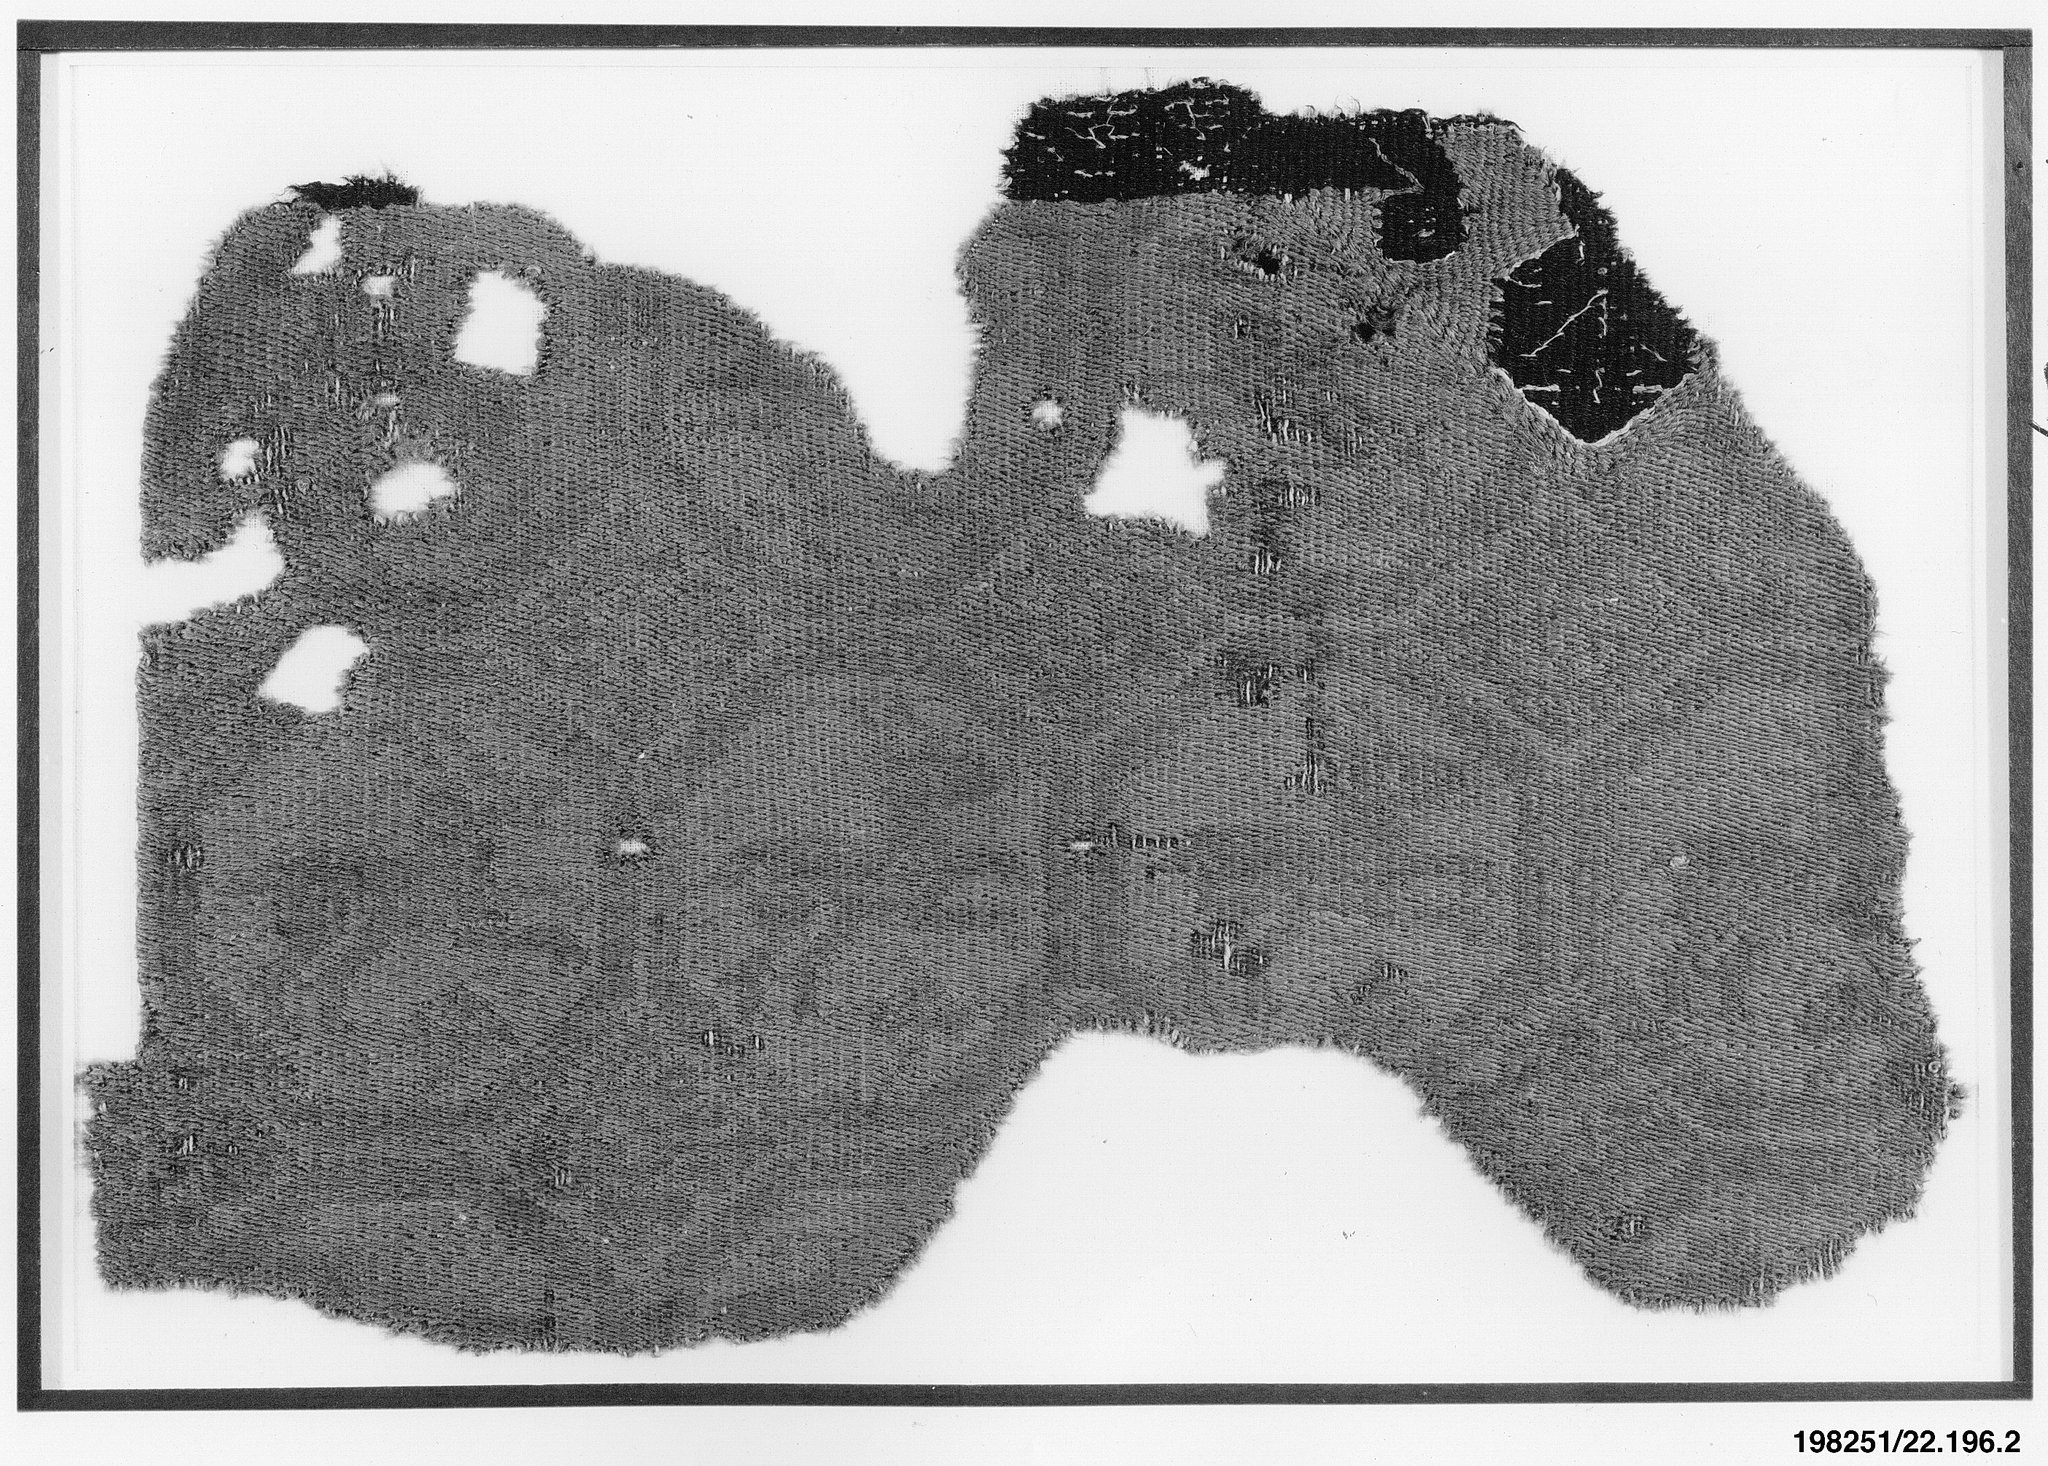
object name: fragment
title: Textile Fragment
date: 601-700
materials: wool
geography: egypt